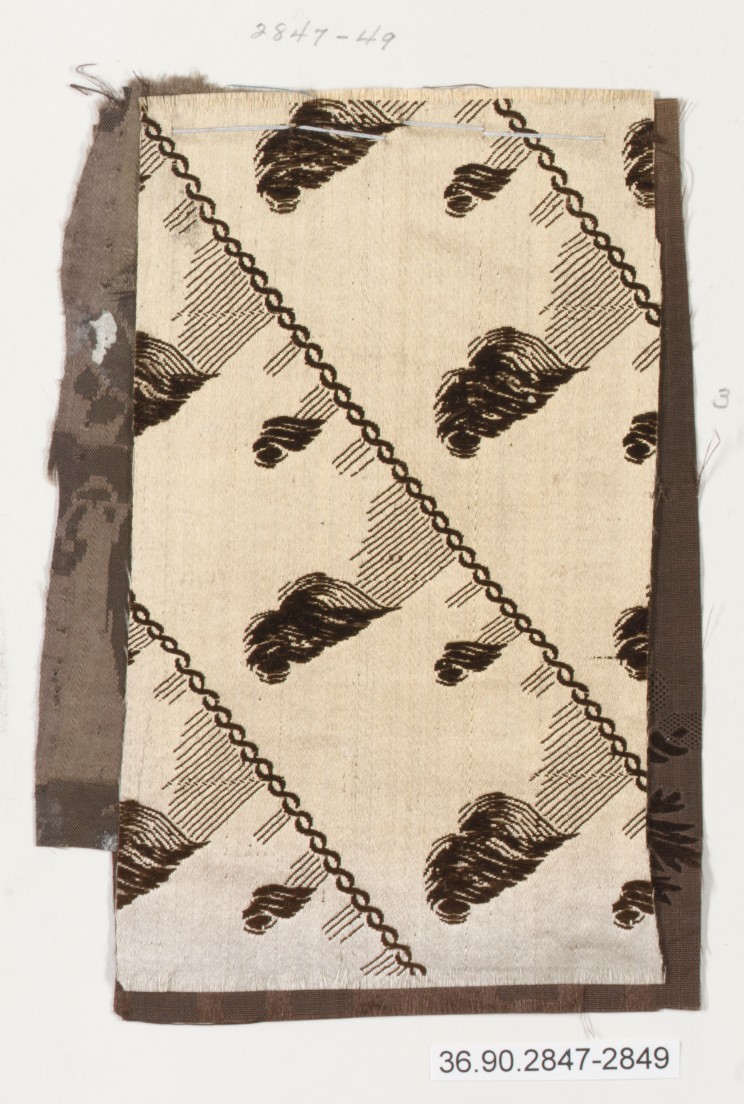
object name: piece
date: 1801-1900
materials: silk